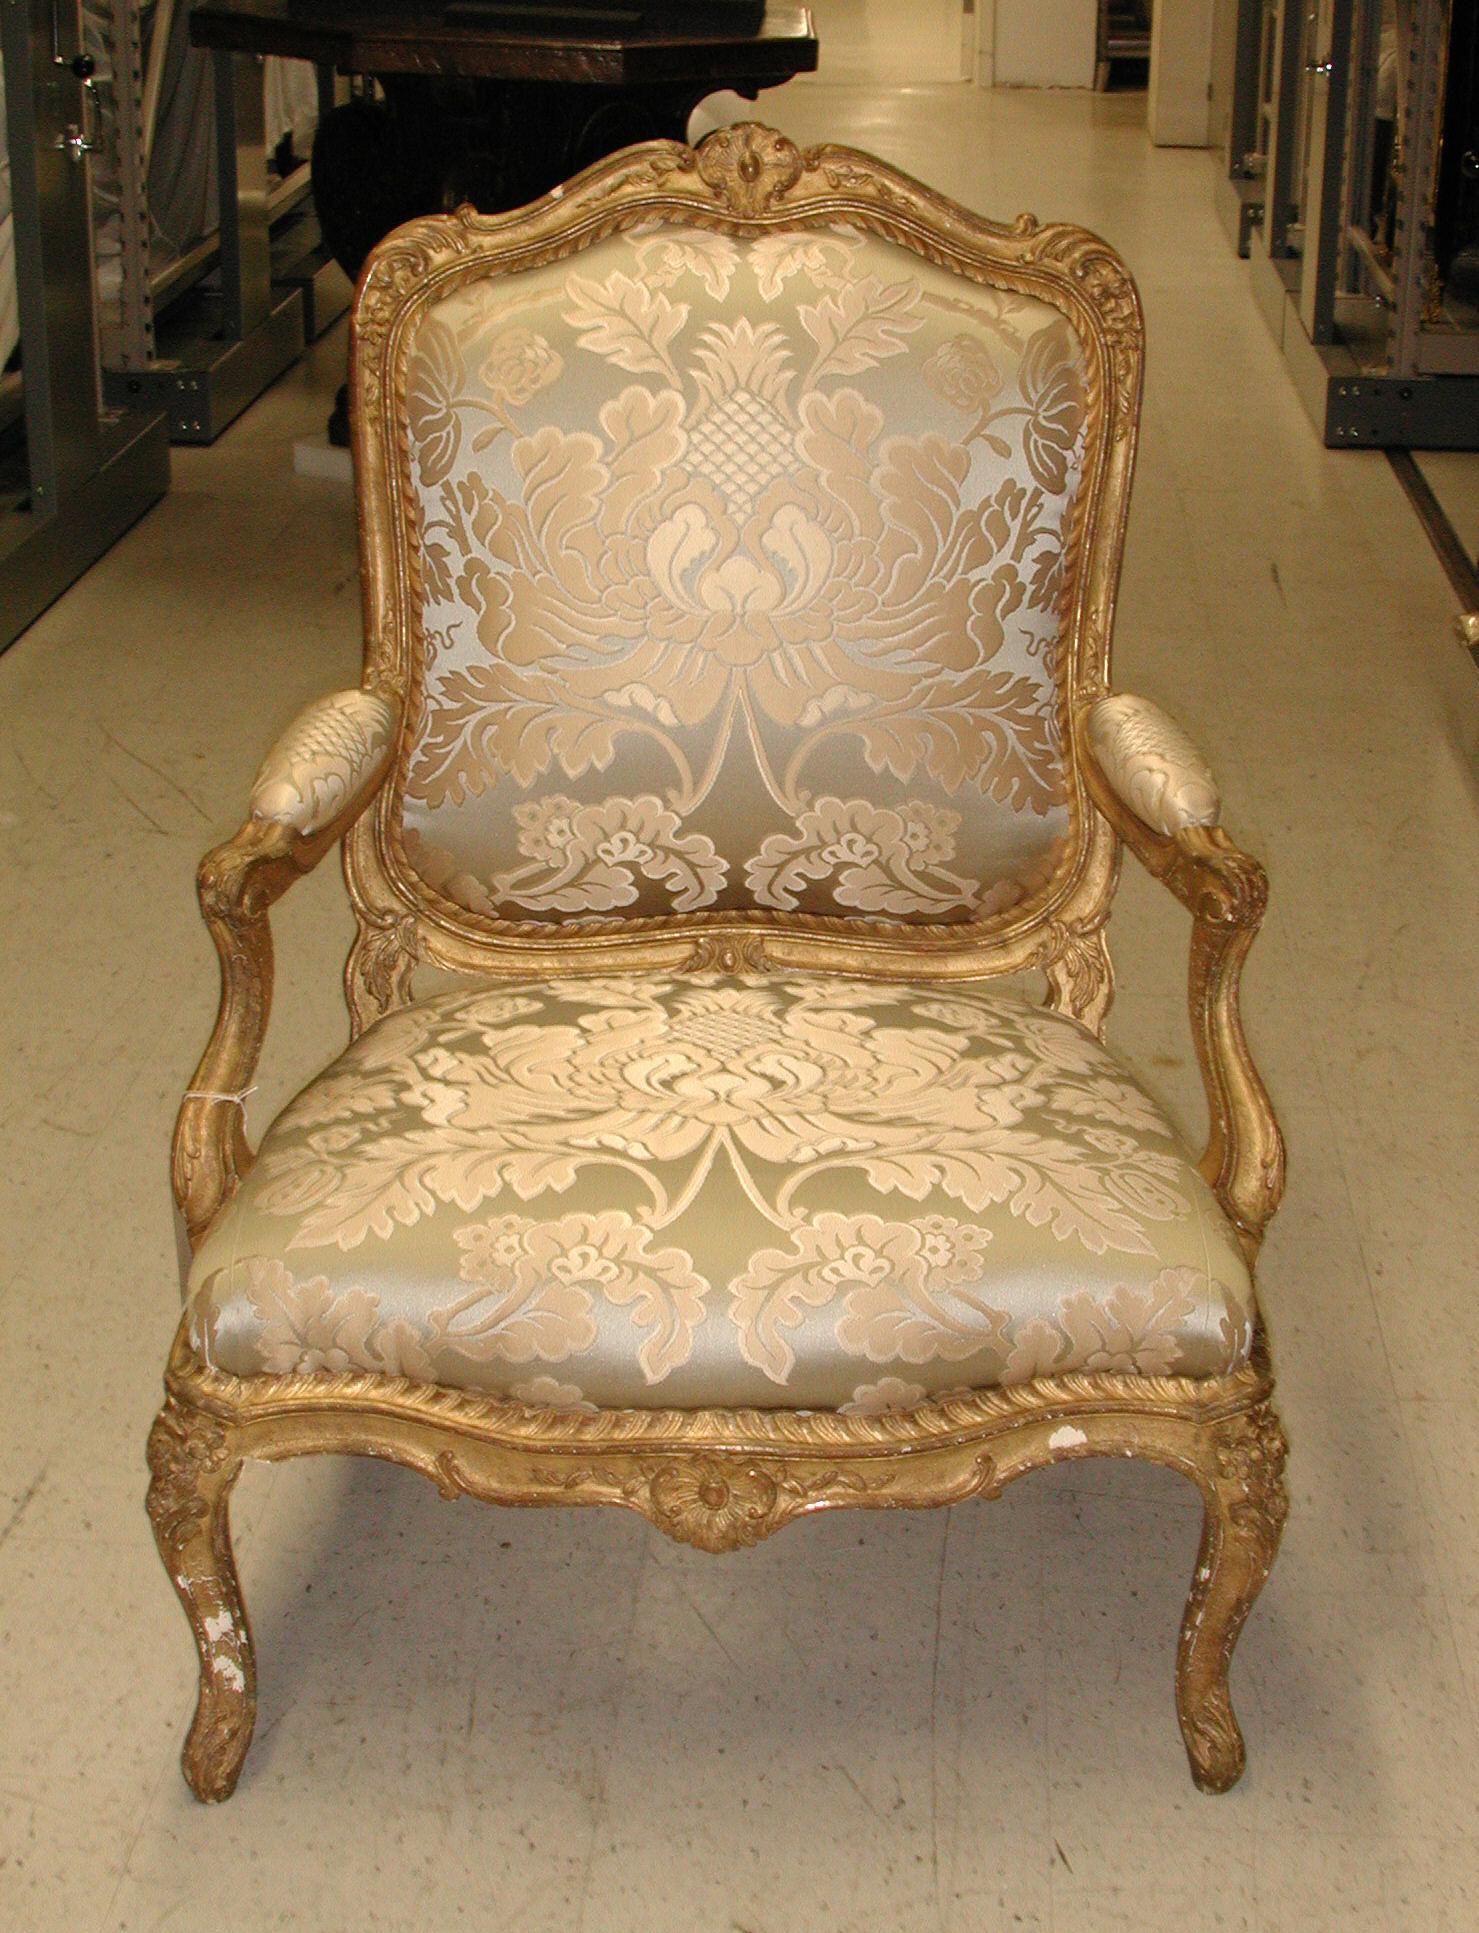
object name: armchair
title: Armchair (one of a pair)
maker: louis i cresson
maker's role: maker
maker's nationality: french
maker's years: 1706-1761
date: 1760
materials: wood, velvet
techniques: carving, gilding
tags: flowers